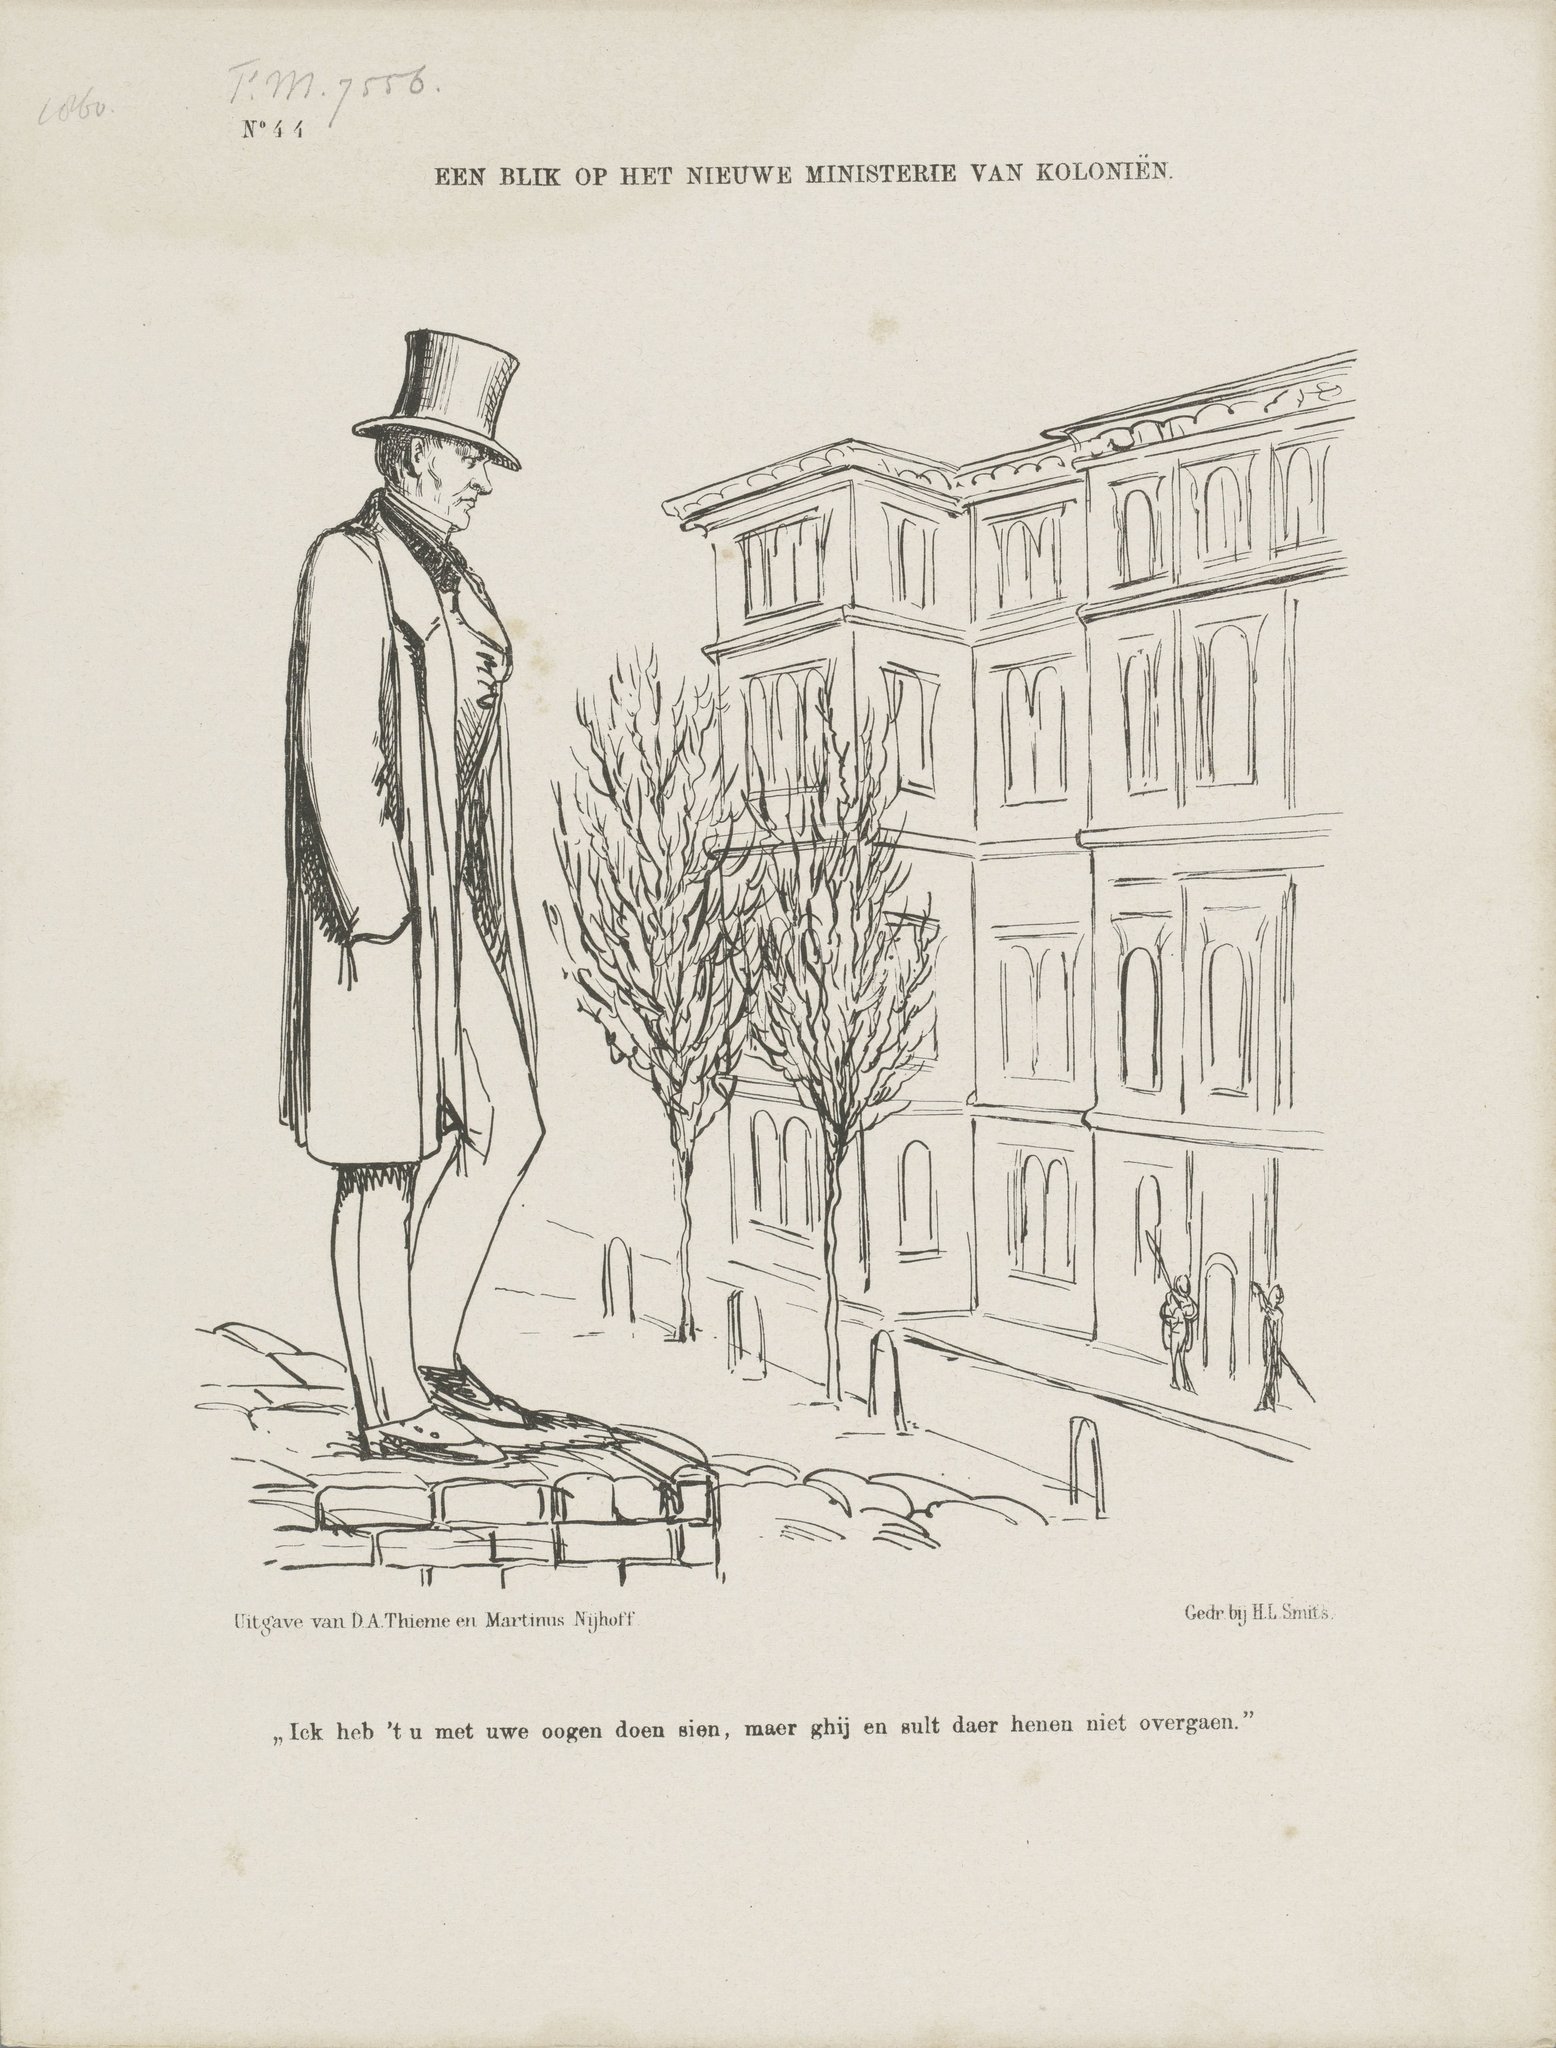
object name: print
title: Spotprent op minister Rochussen en het nieuwe ministerie, 1860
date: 1860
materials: paper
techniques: lithograph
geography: the hague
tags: the hague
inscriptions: collector's mark: Lugt 2228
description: Spotprent op minister J.J. Rochussen die neerziet op het nieuwe Ministerie van Koloniën, net als Mozes die op de Berg Nebo neerziet op het beloogfde land dat hij niet binnen mag treden. Plaat verschenen bij het weekblad De Nederlandsche Spectator, nr. 44, 3 november 1860.